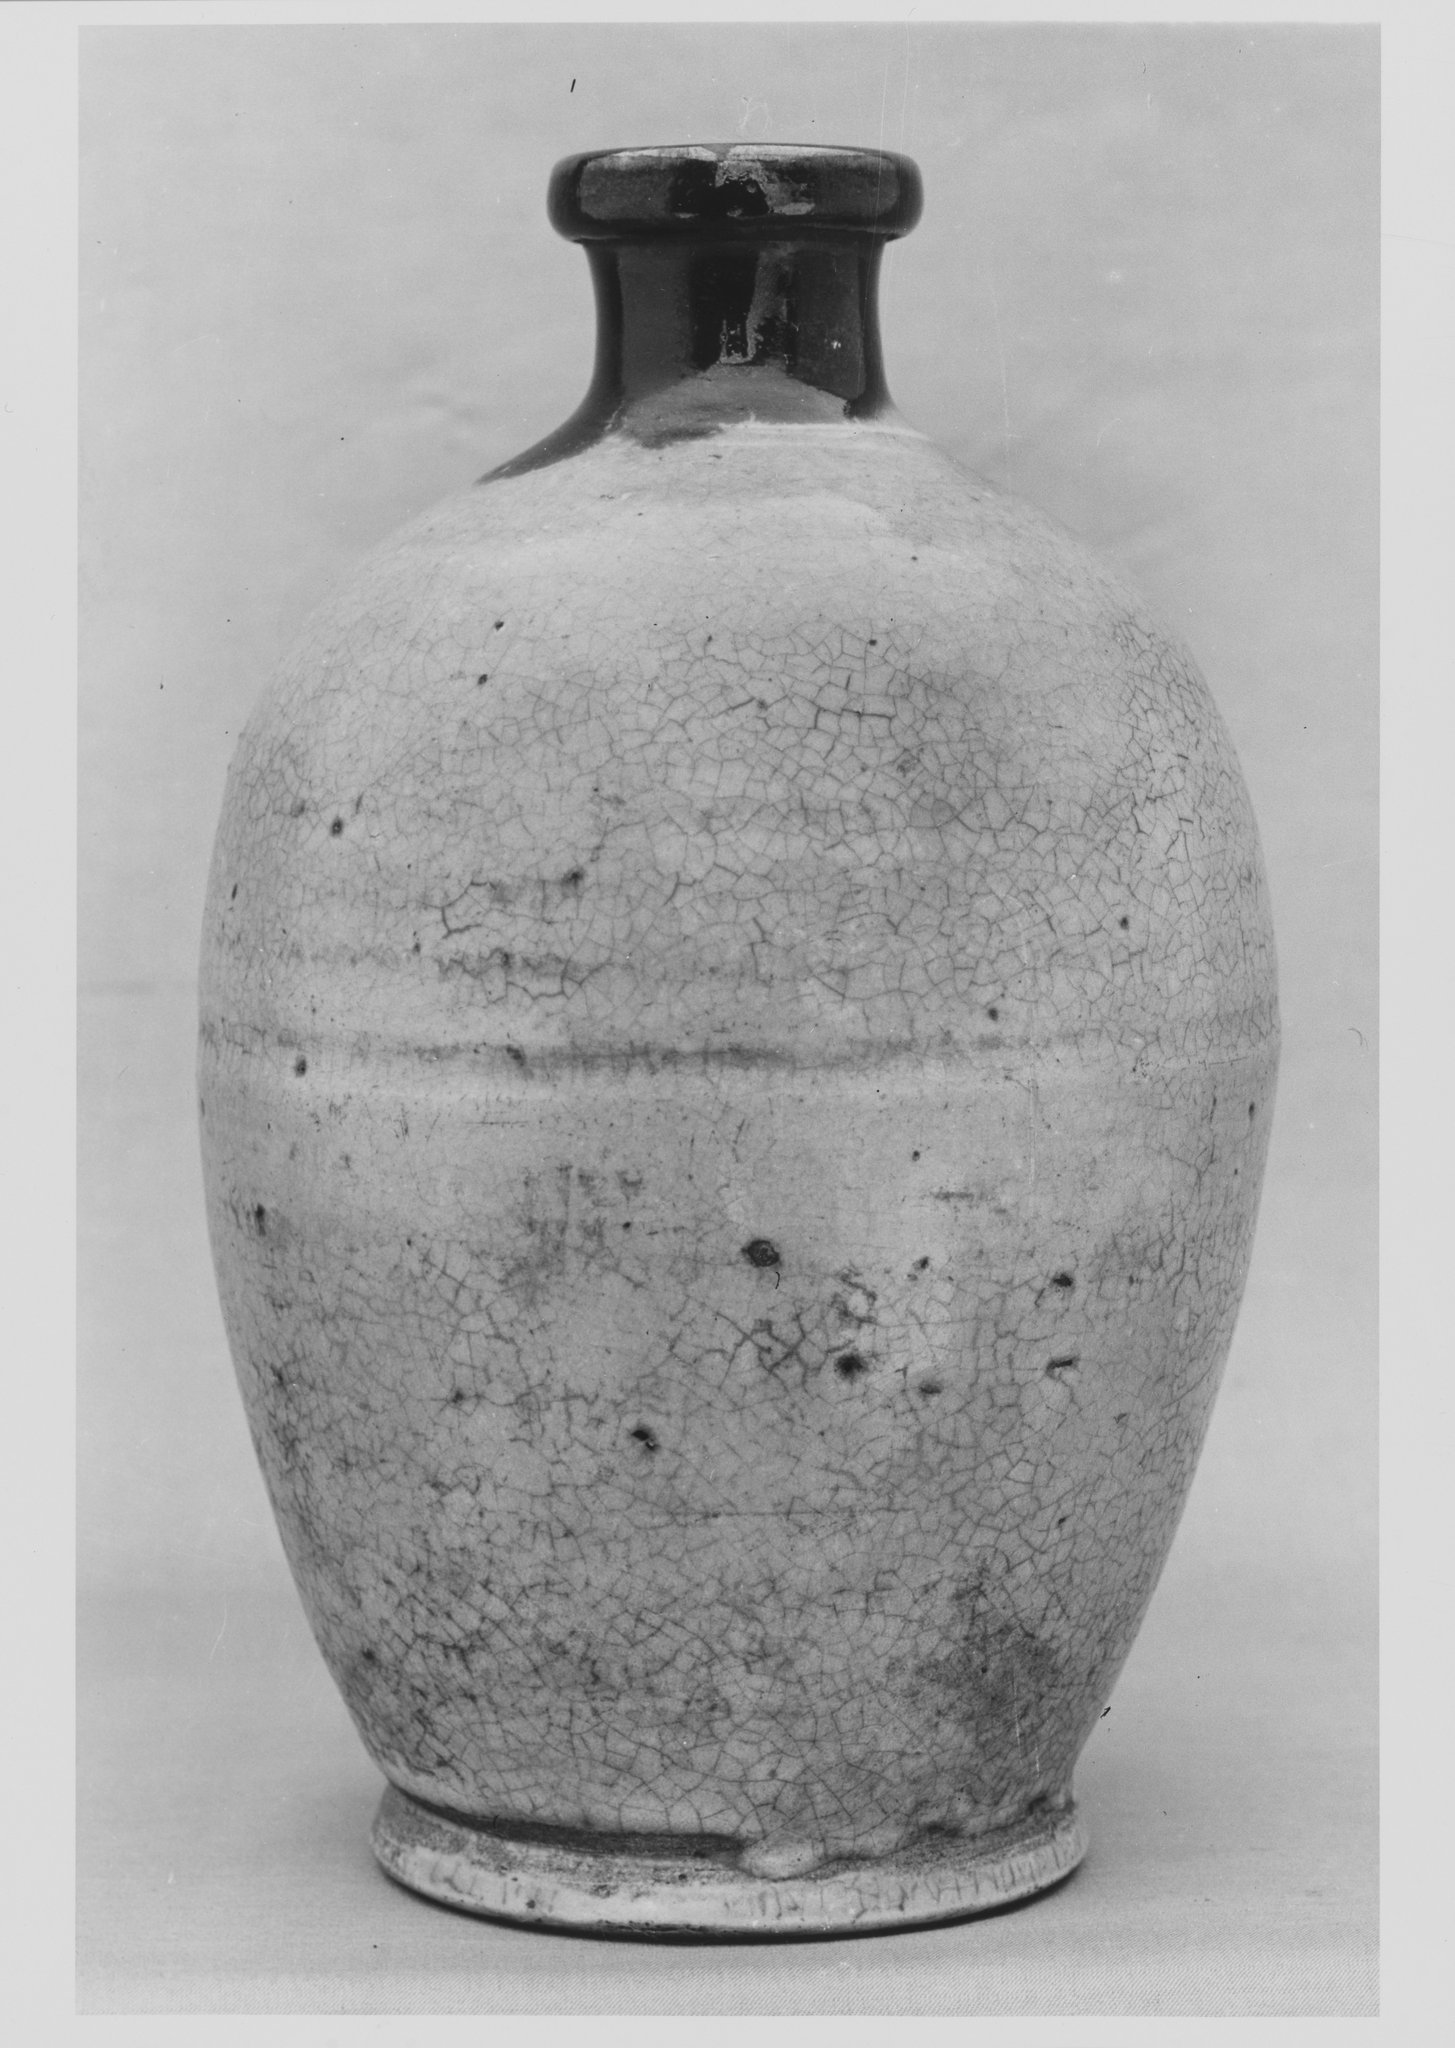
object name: wine bottle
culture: japanese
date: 1801-1900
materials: clay, glaze